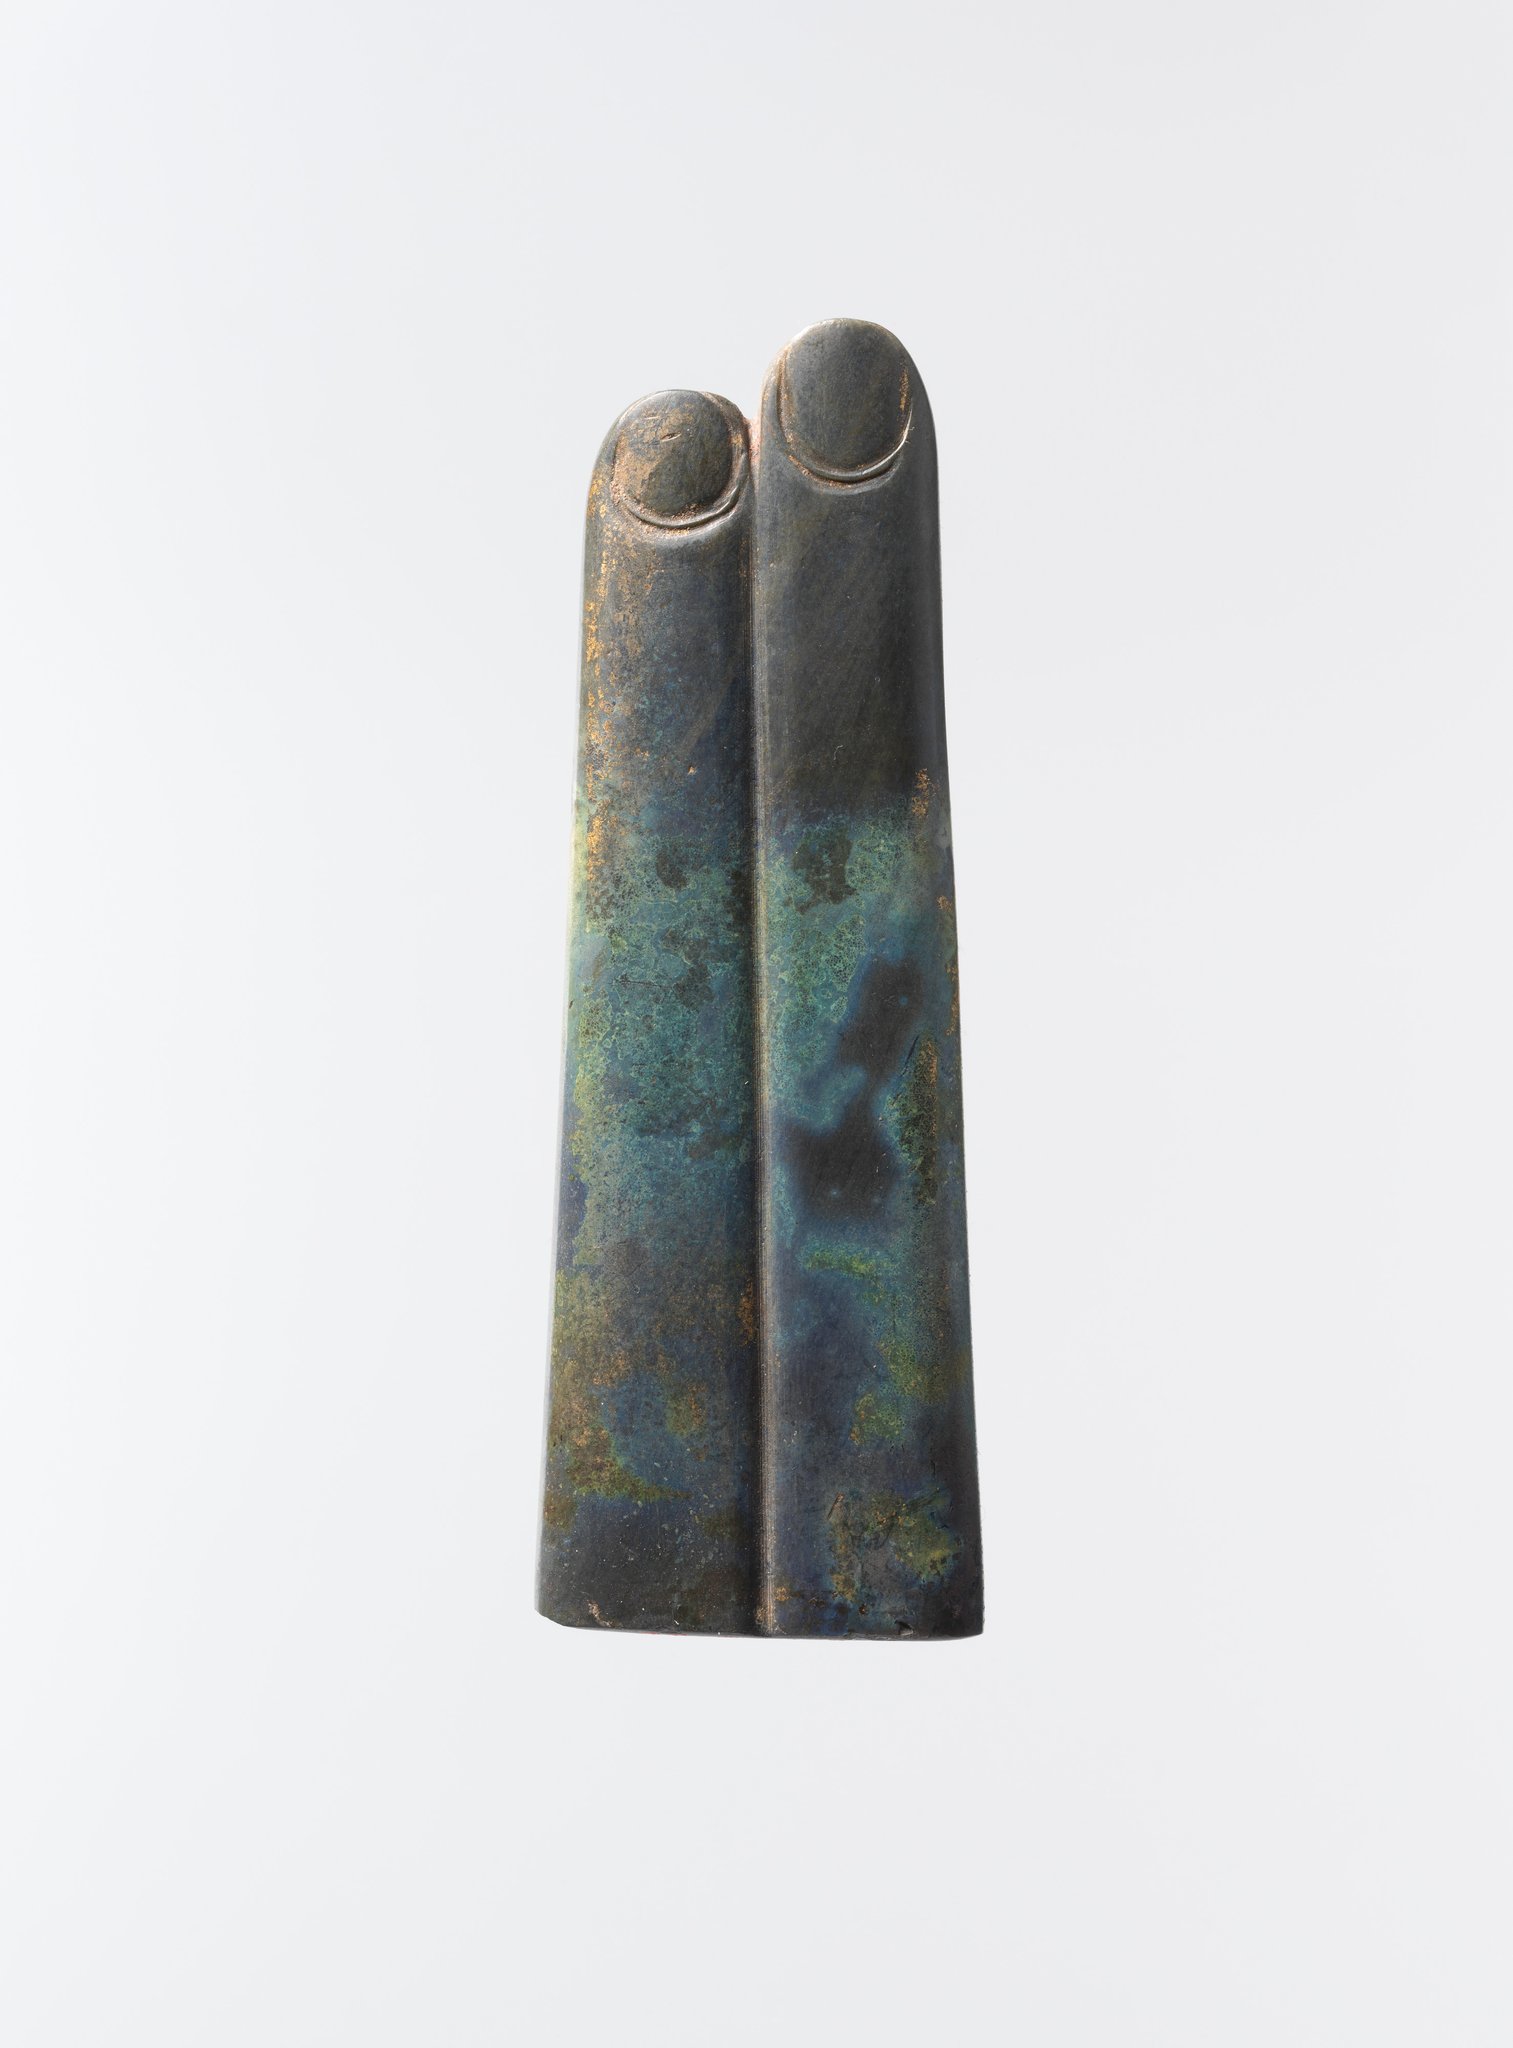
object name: amulet, two finger amulet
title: Two-finger amulet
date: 664-332 BCE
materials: glass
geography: egypt